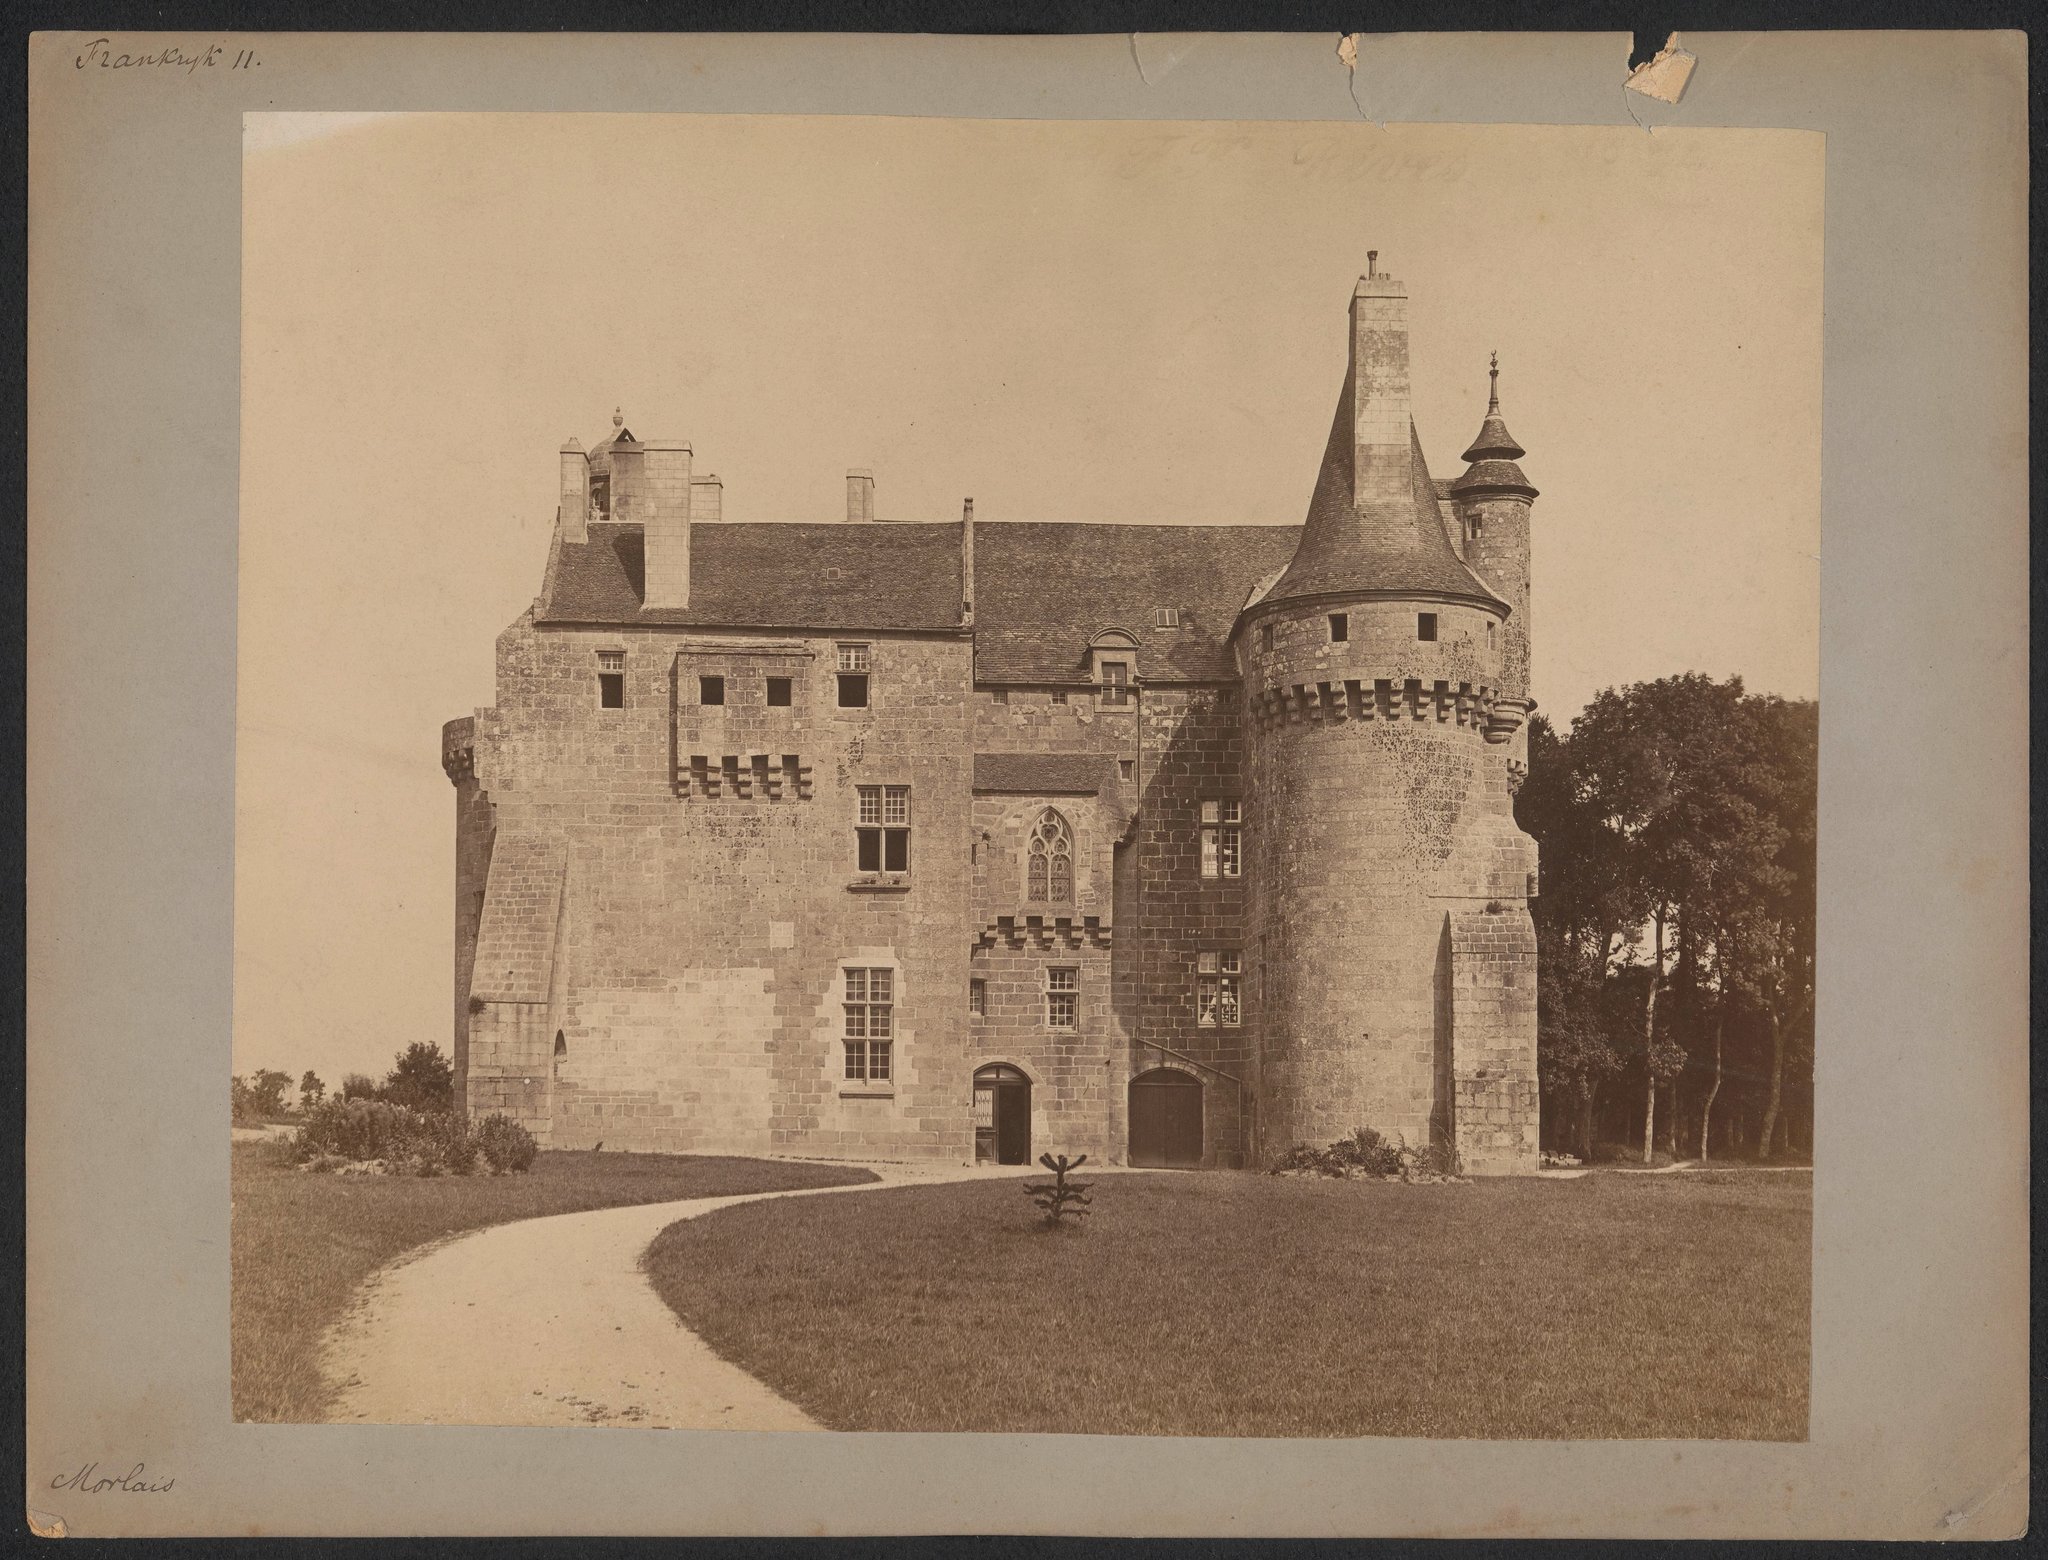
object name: photograph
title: Gezicht op een kasteel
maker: b. f. rives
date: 1850-1900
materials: cardboard, photographic support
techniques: albumen print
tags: castle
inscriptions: check stamp: ‘B. F. K. Rives No. 74’, annotation: ‘Morlais’, collector's mark: ‘RIJKS [NORMA]ALSCHOOL voor T[EEKENONDERWIJZERS] AMSTERDA[M]’, annotation: ‘Frankrijk 11.’, annotation: ‘Morlais’, annotation: ‘Morlais’